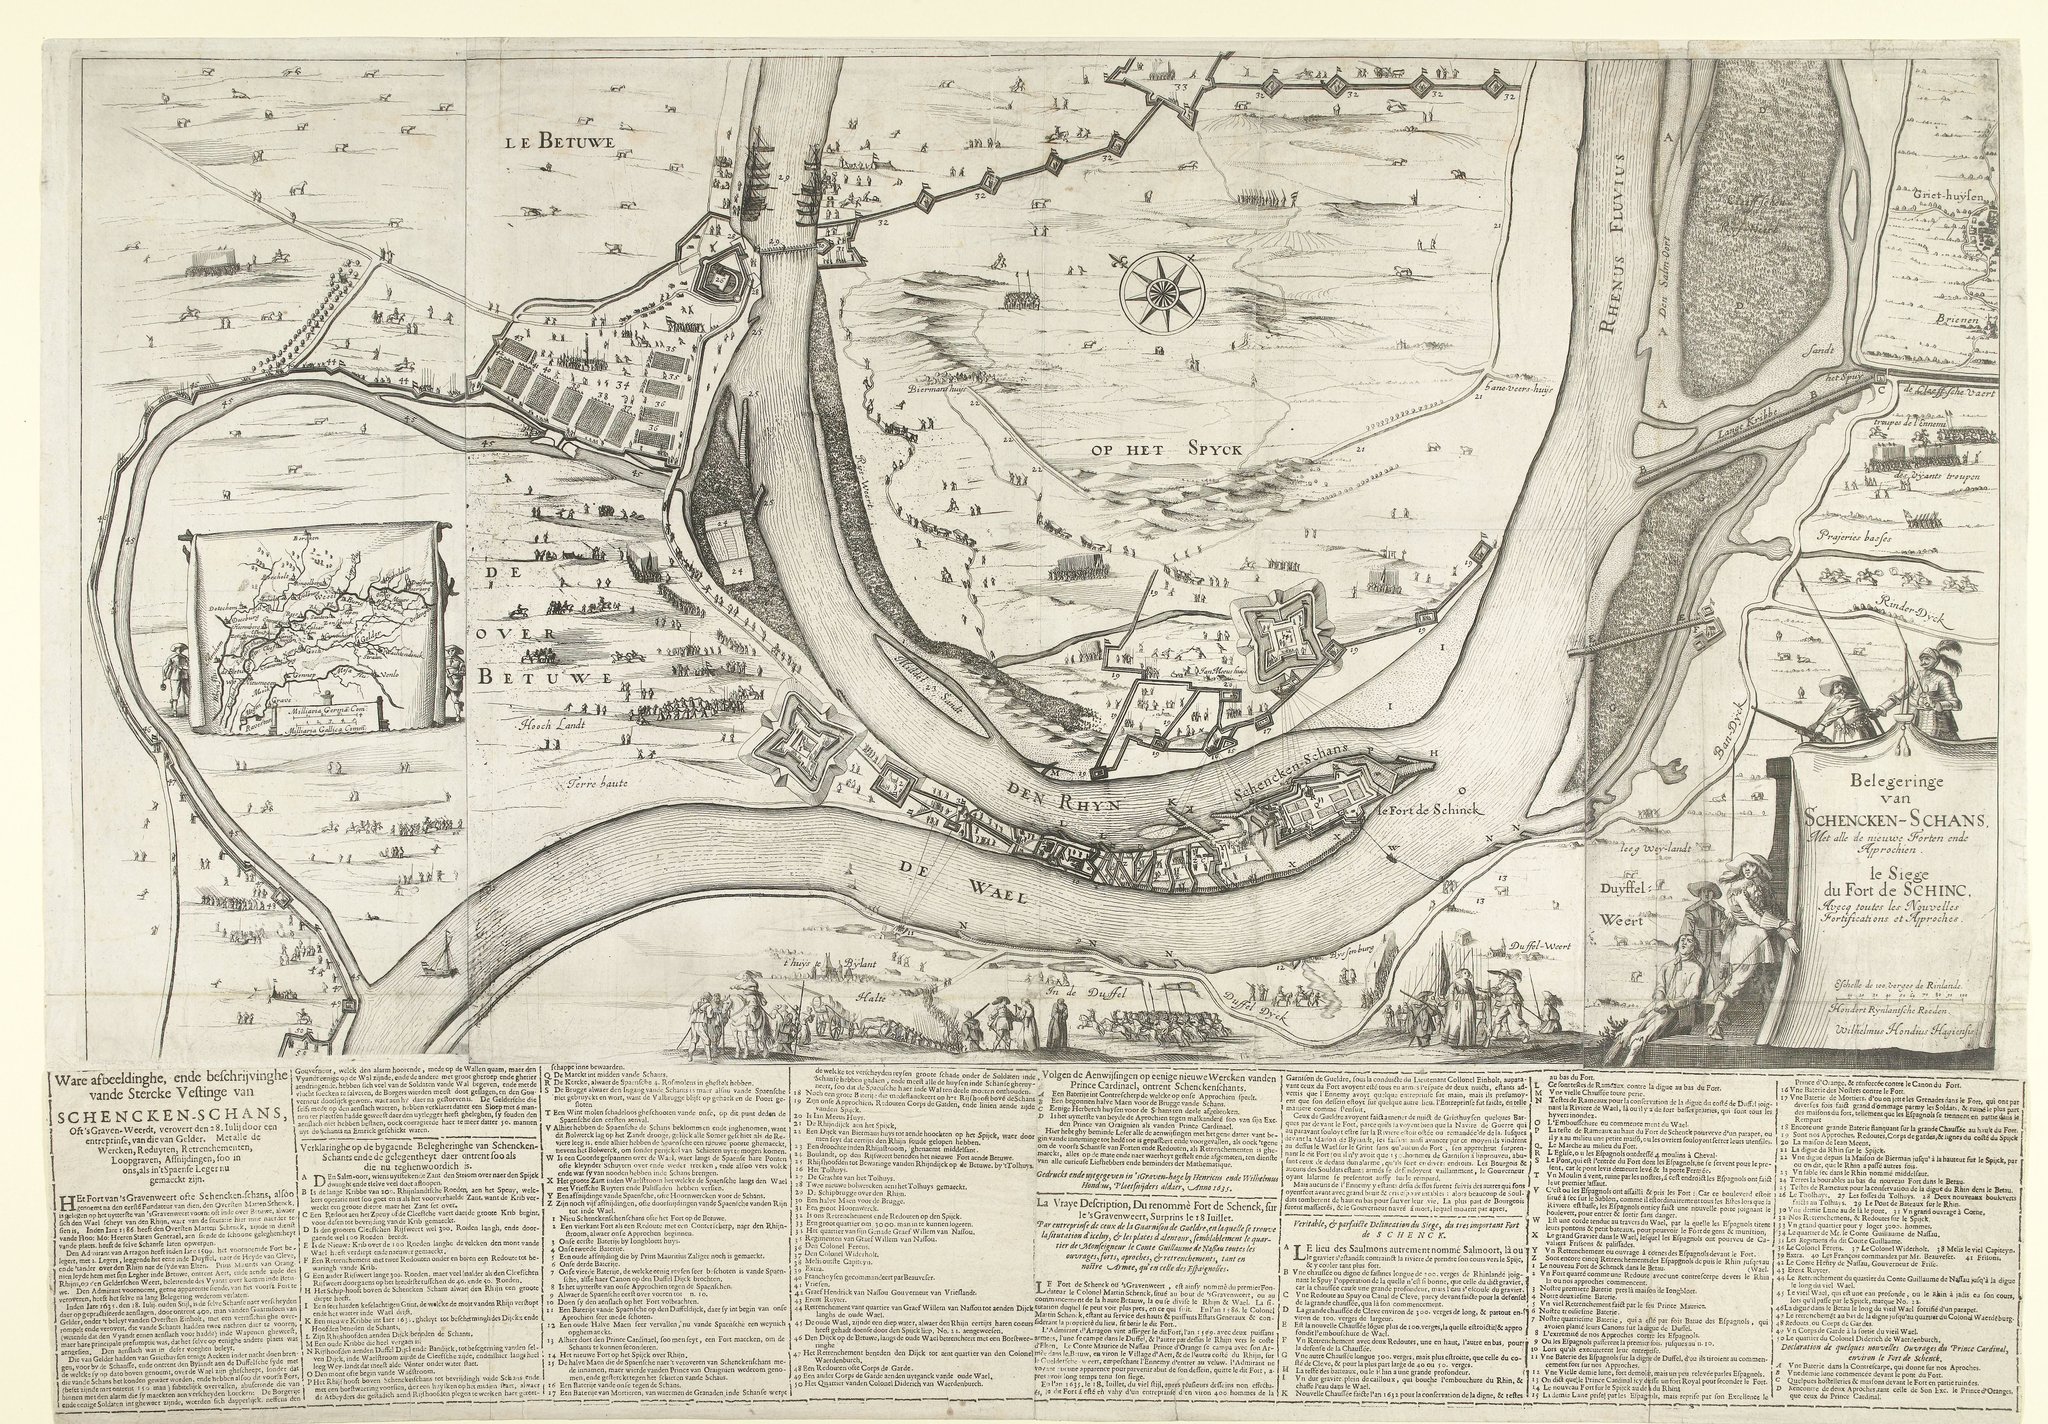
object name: print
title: Belegeringe van Schencken-Schans, Met alle de nieuwe Forten ende Approchien / le Siege du Fort de Schinc, Avecq toutes les Nouvelles Fortifications et Approches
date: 1635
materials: paper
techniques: engraving, etching, letterpress printing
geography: the hague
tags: frederick henry (prince of orange), maps of separate countries or regions, siege, position war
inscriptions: date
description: Kaart van het beleg van het door de Spanjaarden op 28 juli 1635 bij verrassing ingenomen fort Schenckenschans door het Staatse leger onder Frederik Hendrik, sinds 30 juli 1635. Grote kaart op drie bladen met de ligging van het fort Schenckenschans op de splitsing van Rijn en Waal. Links een inzet met een kaart van het groter gebied, rechts een door soldaten opgehouden doek met de titels. Onder de prent zijn twee tekstbladen geplakt met beschrijvingen en de legenda's A-Z en 1-50 in het Nederlands en Frans.